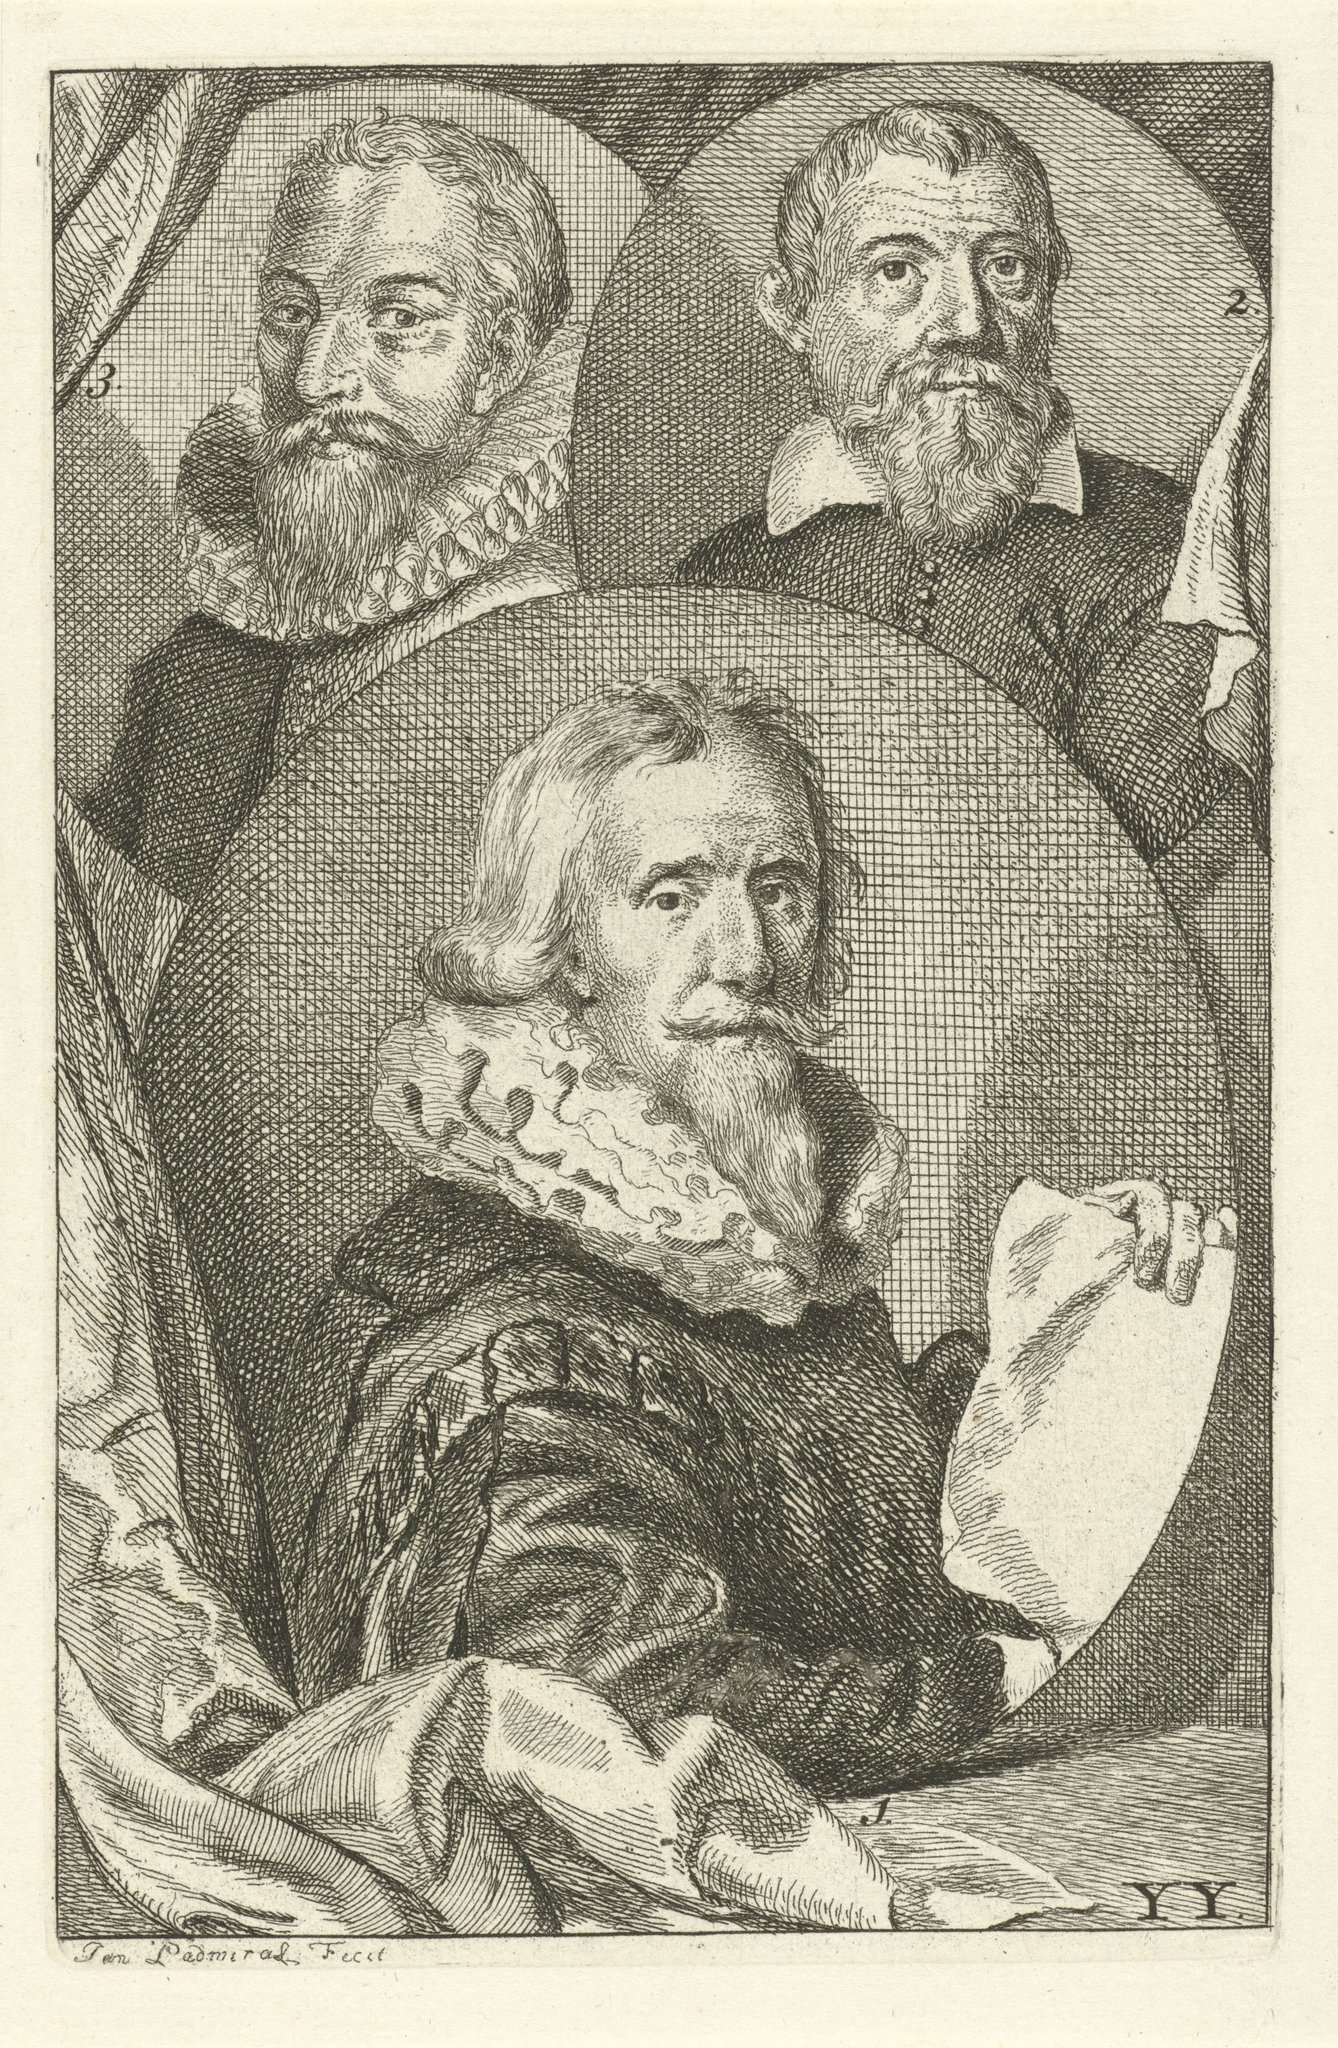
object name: print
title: Portretten van Paulus Moreelse, Balthasar Lauwers en Floris Claesz. van Dijck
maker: jan l admiral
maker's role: draughtsman, print maker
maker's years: 1699-1773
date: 1764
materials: paper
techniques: etching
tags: utrecht, print maker, paulus moreelse, haarlem, painter, floris claesz van dijck, antwerp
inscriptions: collector's mark: Lugt 2228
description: Prent opgenomen in: Mander, Karel van; Jongh, Jacobus de (vert.). Het leven der doorluchtige Nederlandsche en eenige Hoogduitsche schilders. Amsterdam: Steven van Esveldt, 1764.